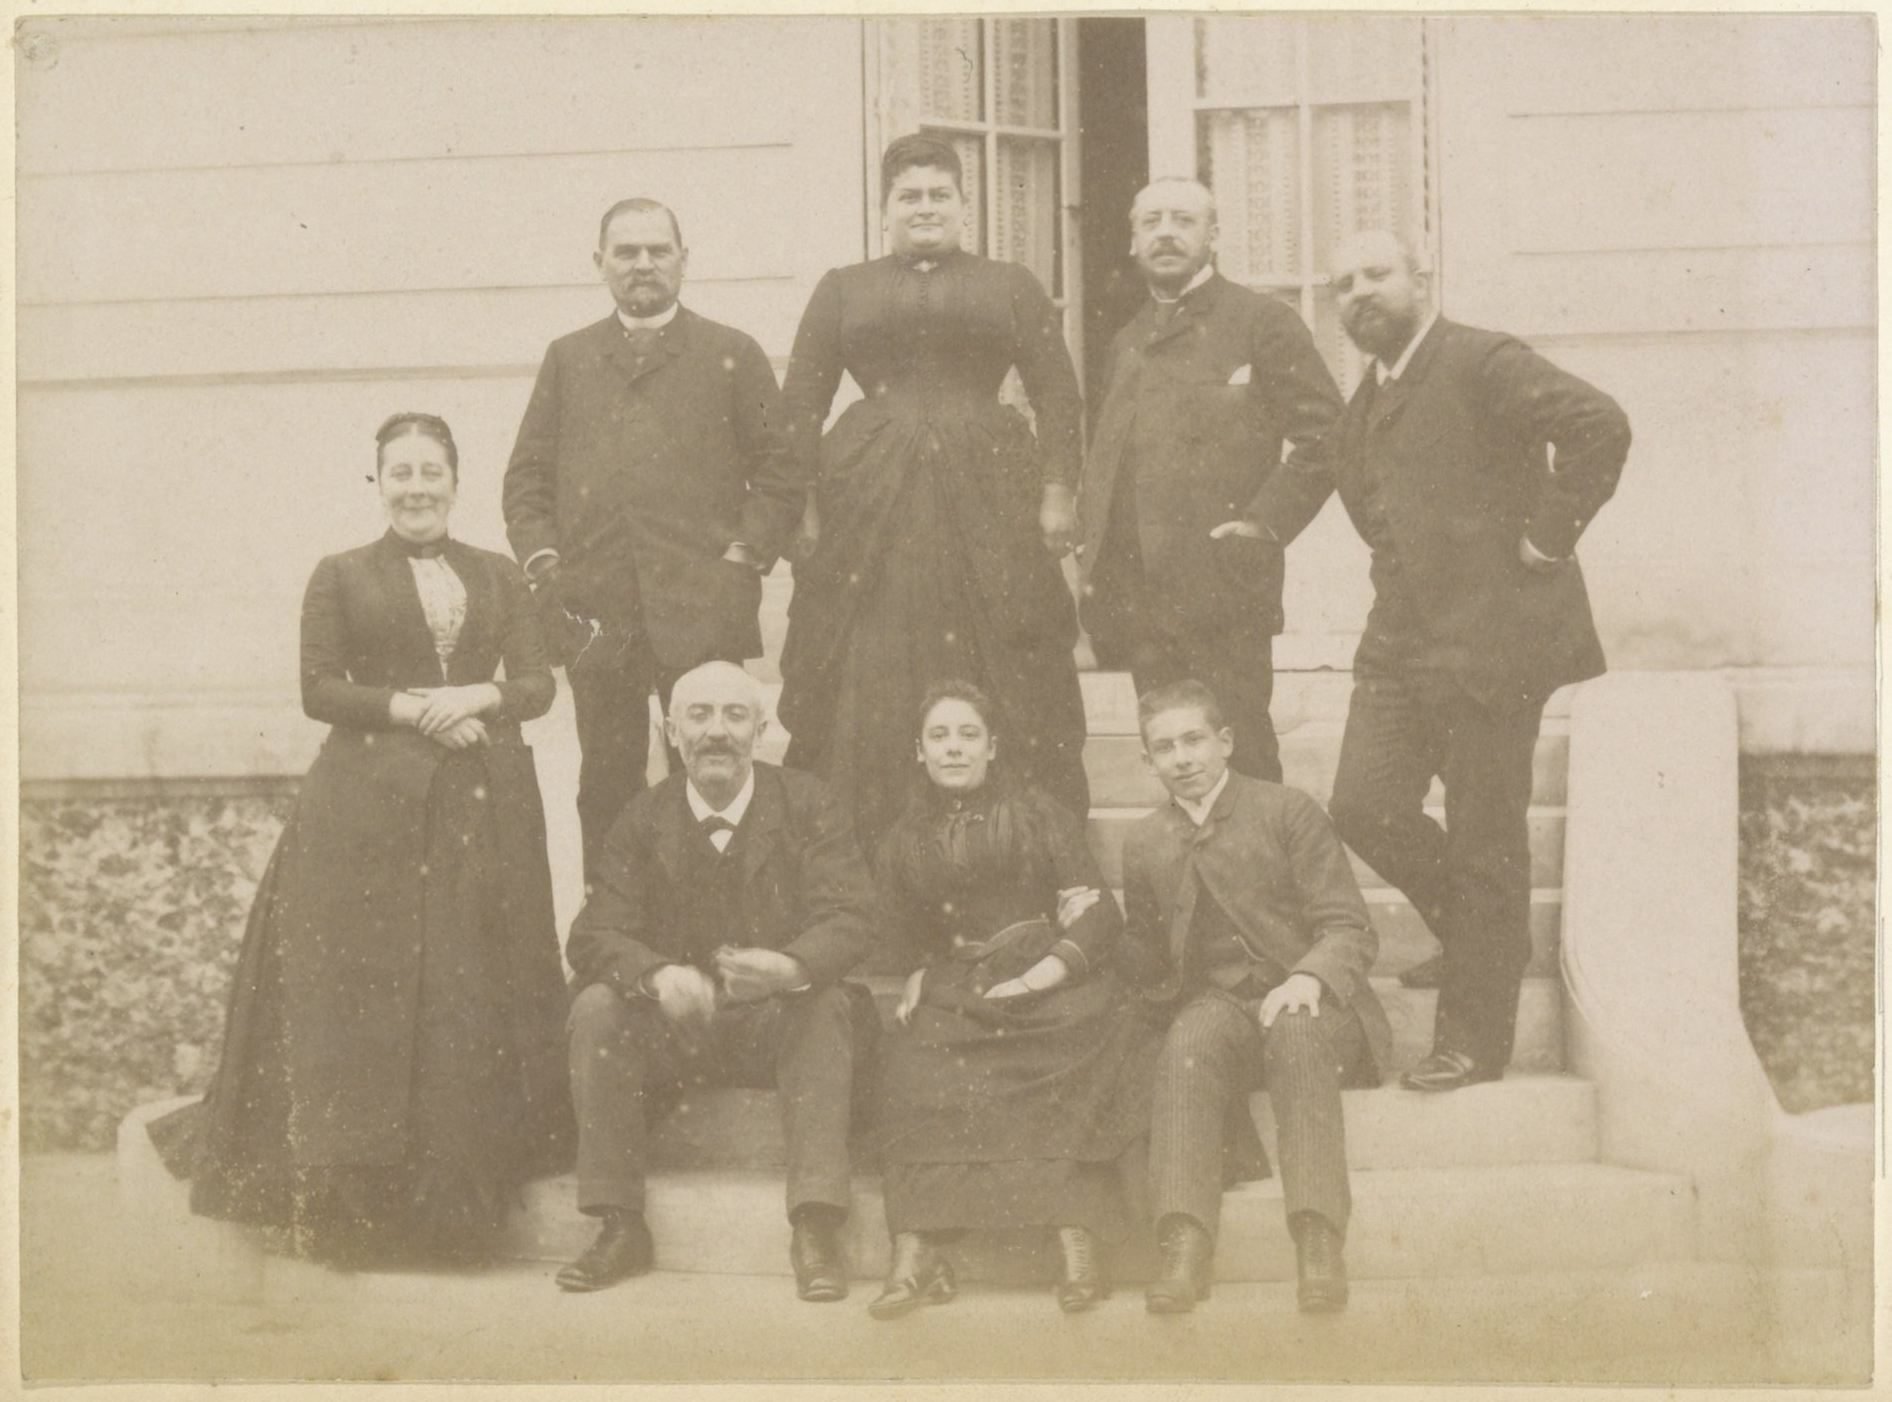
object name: photograph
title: Groepsportret van een Franse familie op de trappen voor een huis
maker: Anonymous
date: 1900-1910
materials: paper, photographic support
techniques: albumen print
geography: france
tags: three generations (family group), france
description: Onderdeel van Fotoalbum van een Franse amateurfotograaf met opnames van een familie, distilleerderij Delizy & Doistau Fils, het leger en bezienswaardigheden in Frankrijk.